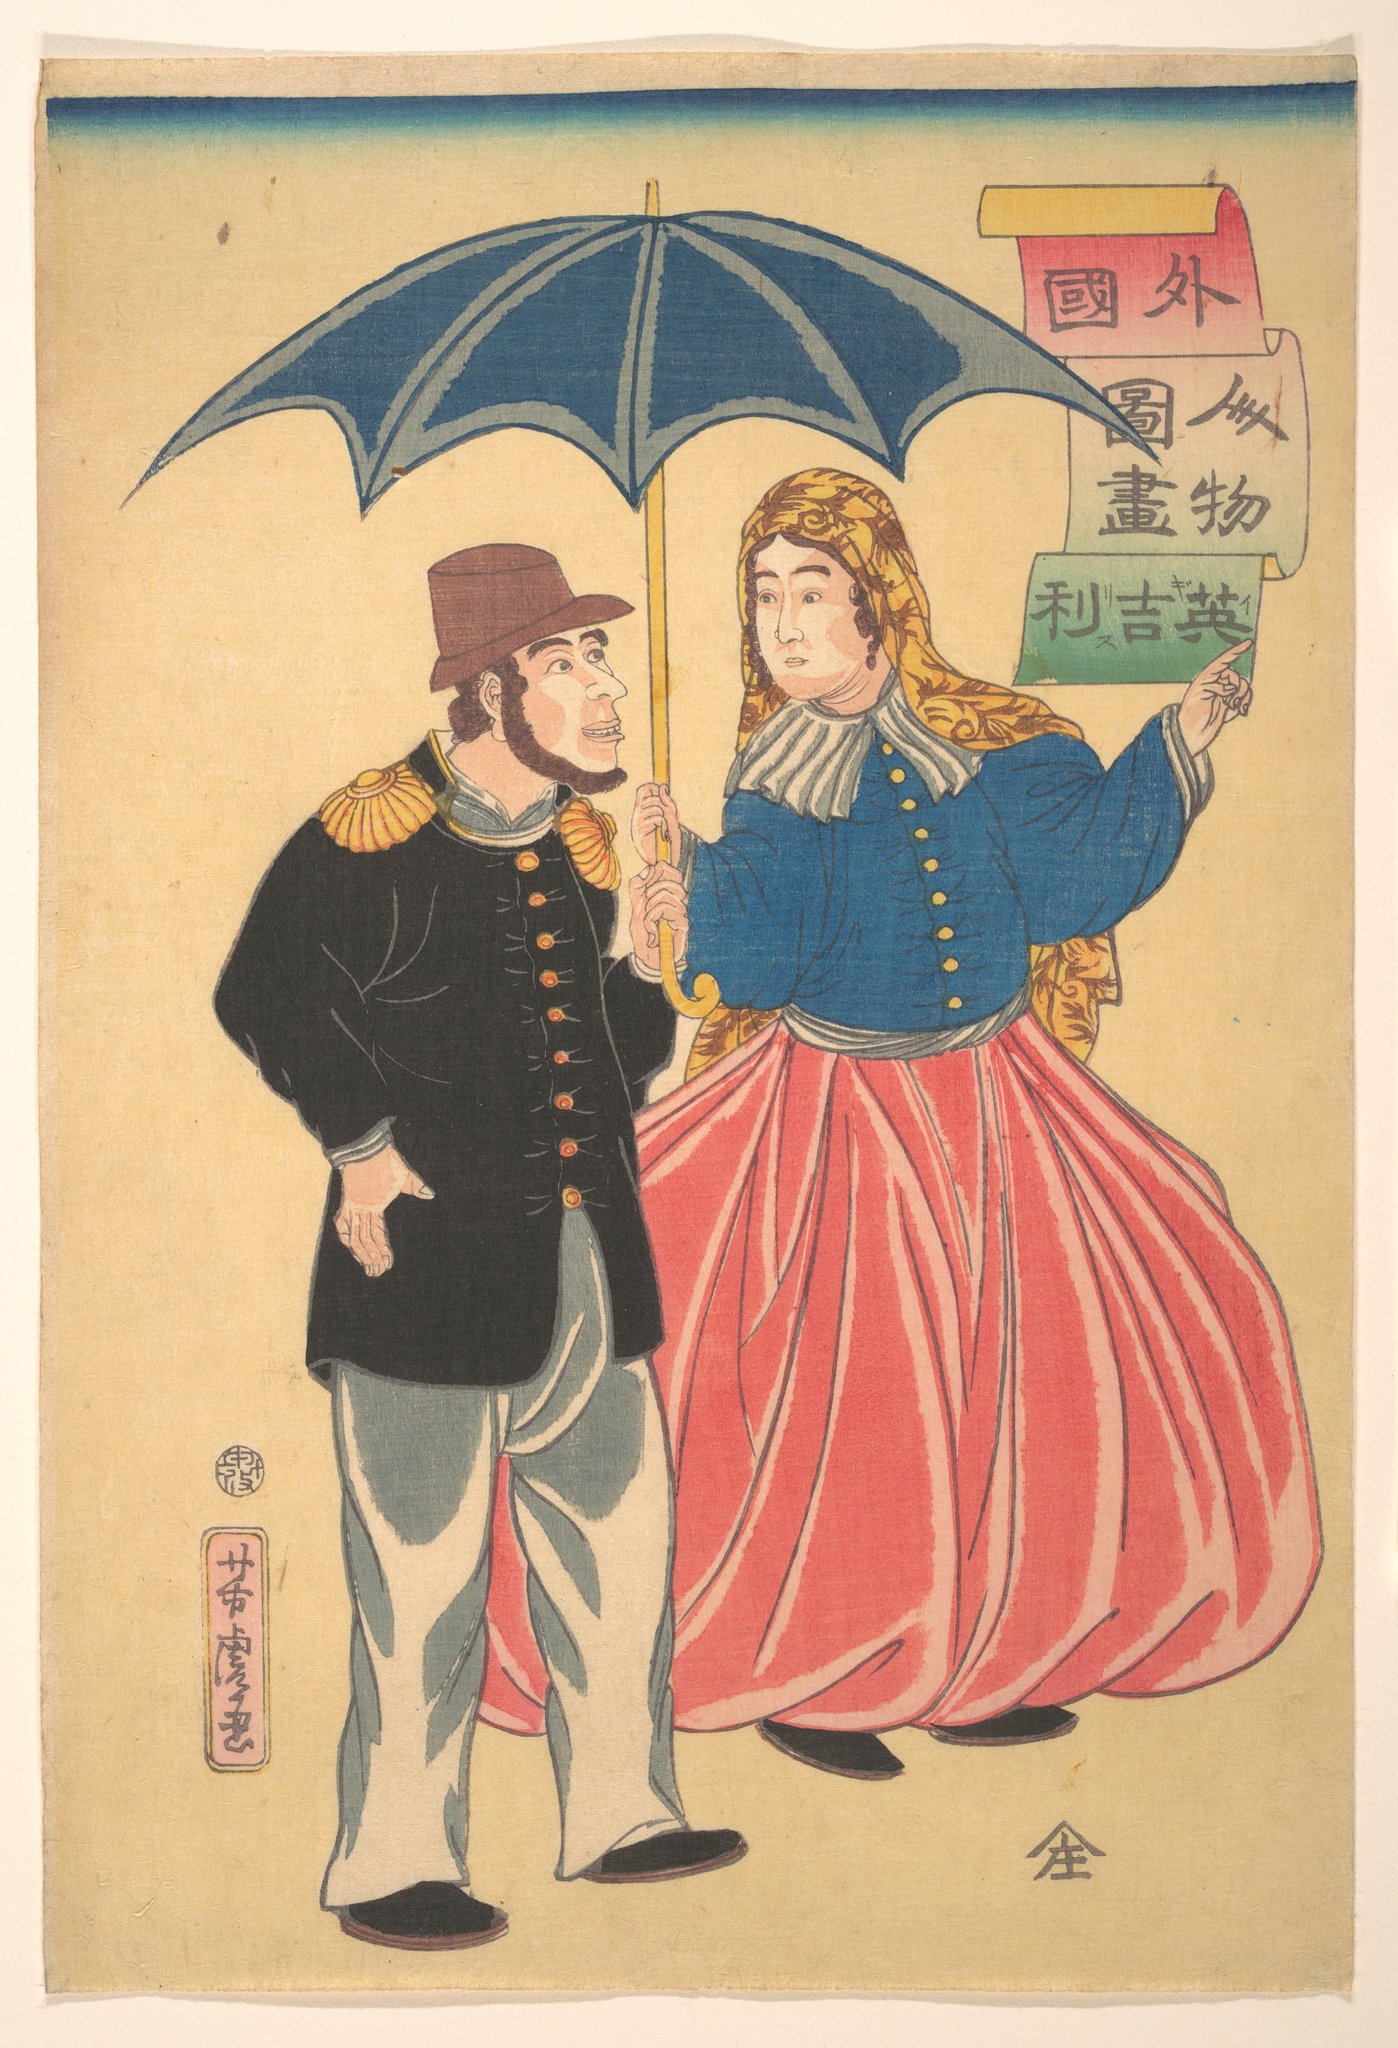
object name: print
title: English Couple (Igirisujin)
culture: japanese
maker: utagawa yoshitora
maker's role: artist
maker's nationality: japanese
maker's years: 1845-1880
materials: ink, paper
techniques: woodblock print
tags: couples